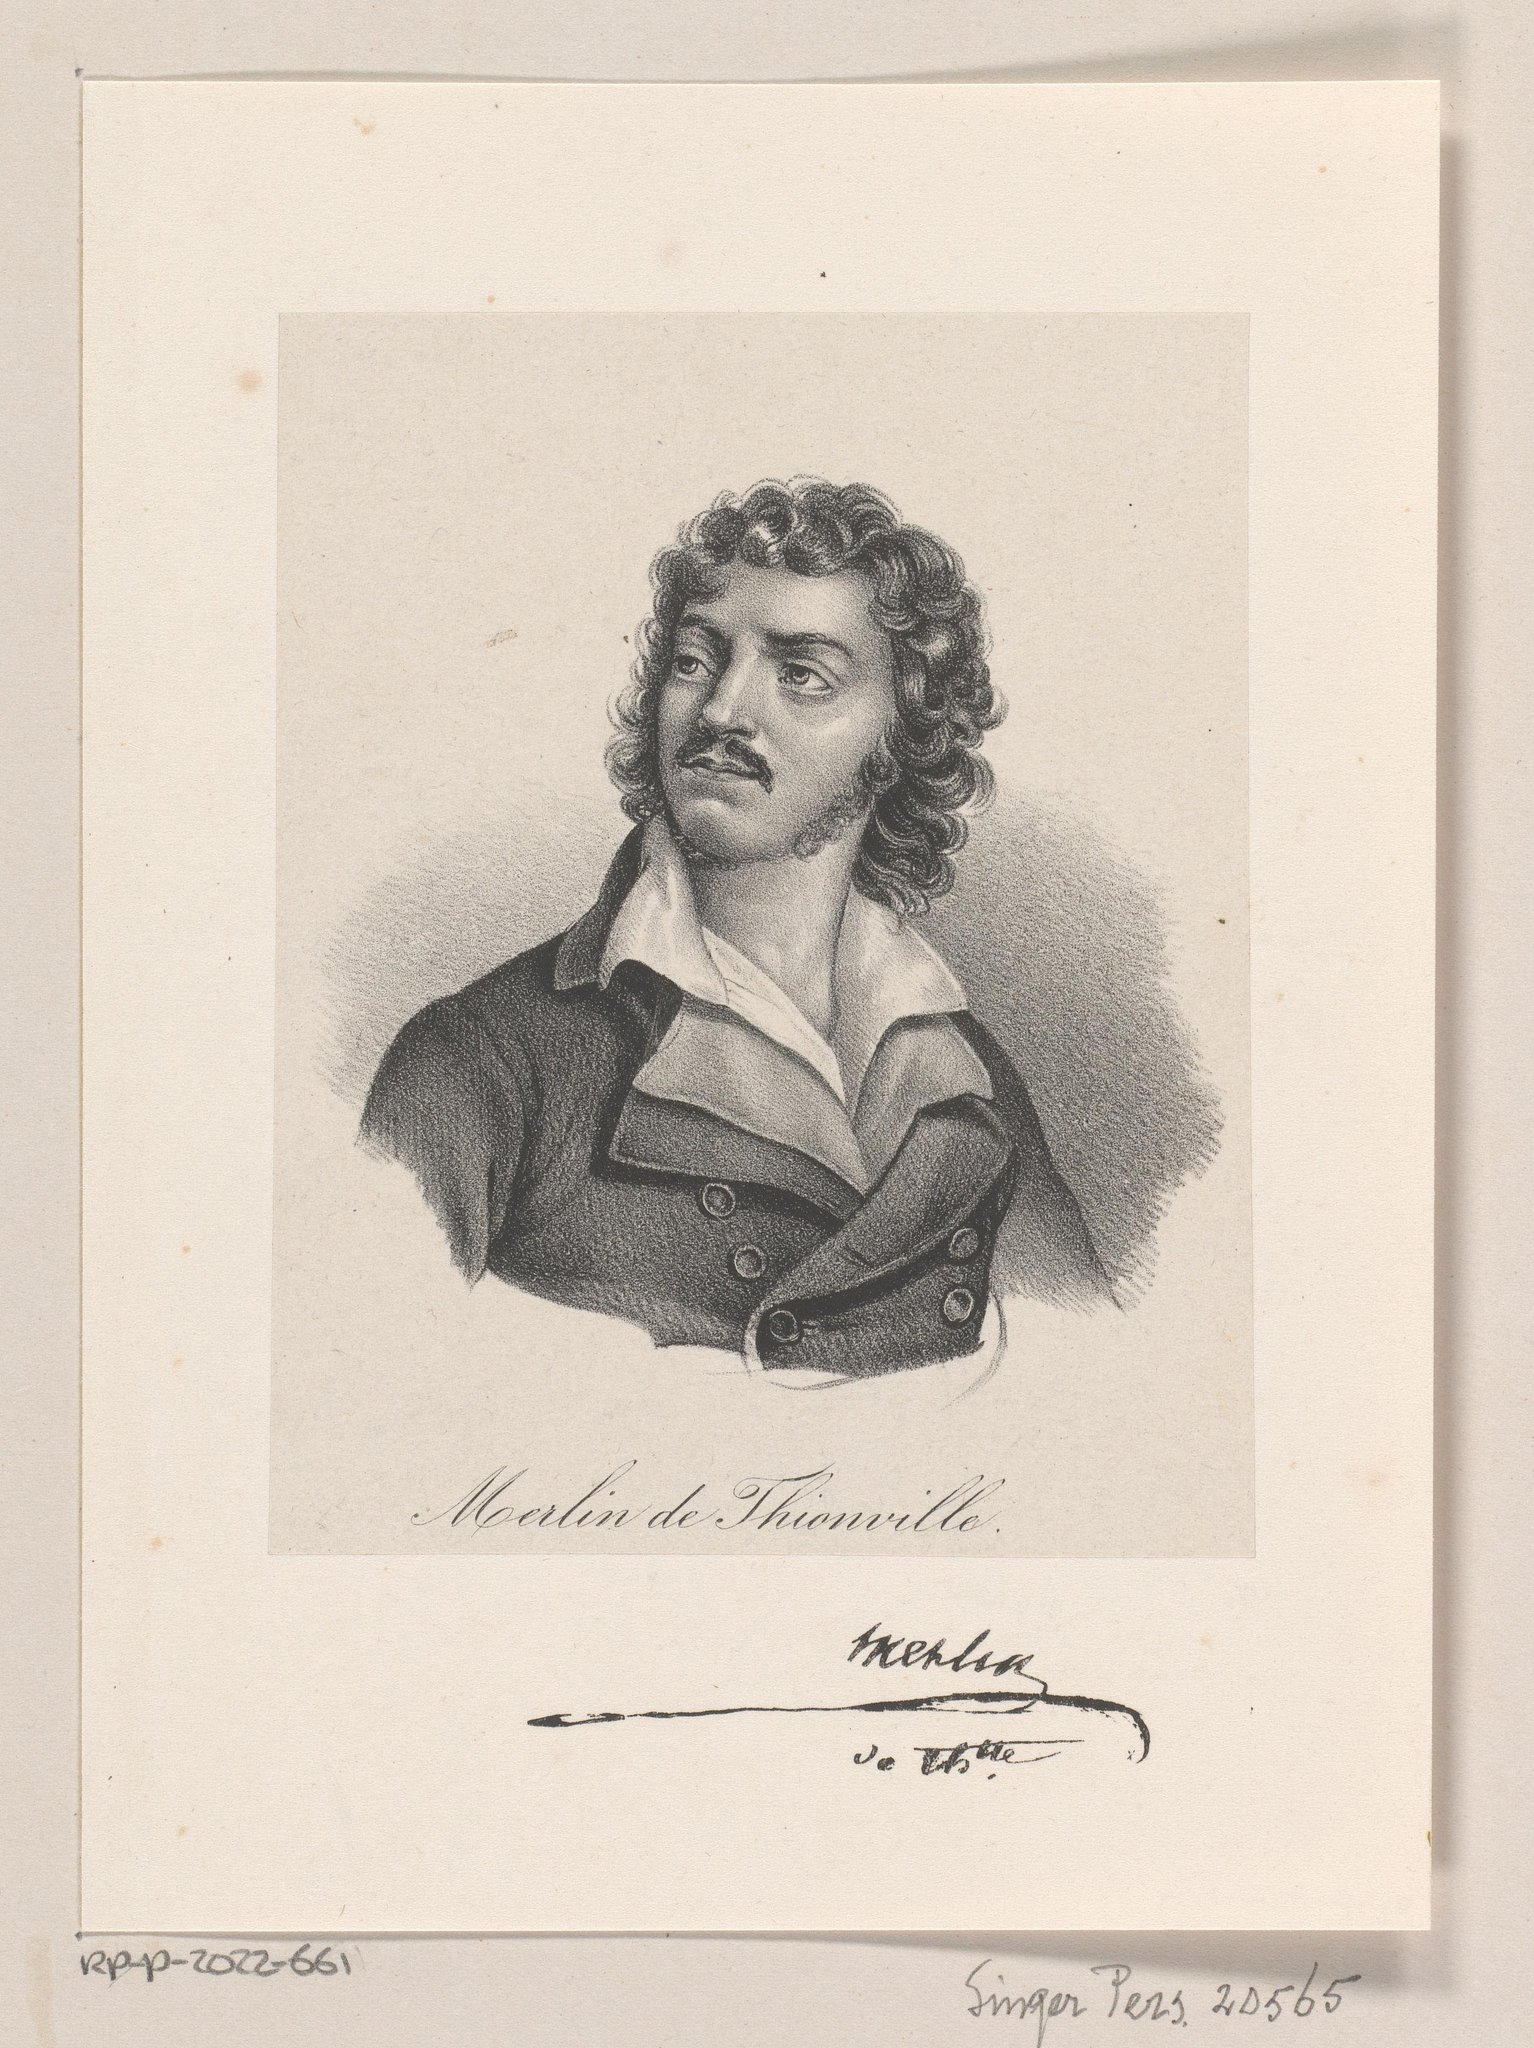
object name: print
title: Portret van Antoine Christophe Merlin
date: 1818-1842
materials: paper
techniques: lithograph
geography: paris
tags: paris, politician, historical persons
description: Met facsimile signatuur van de geportretteerde.